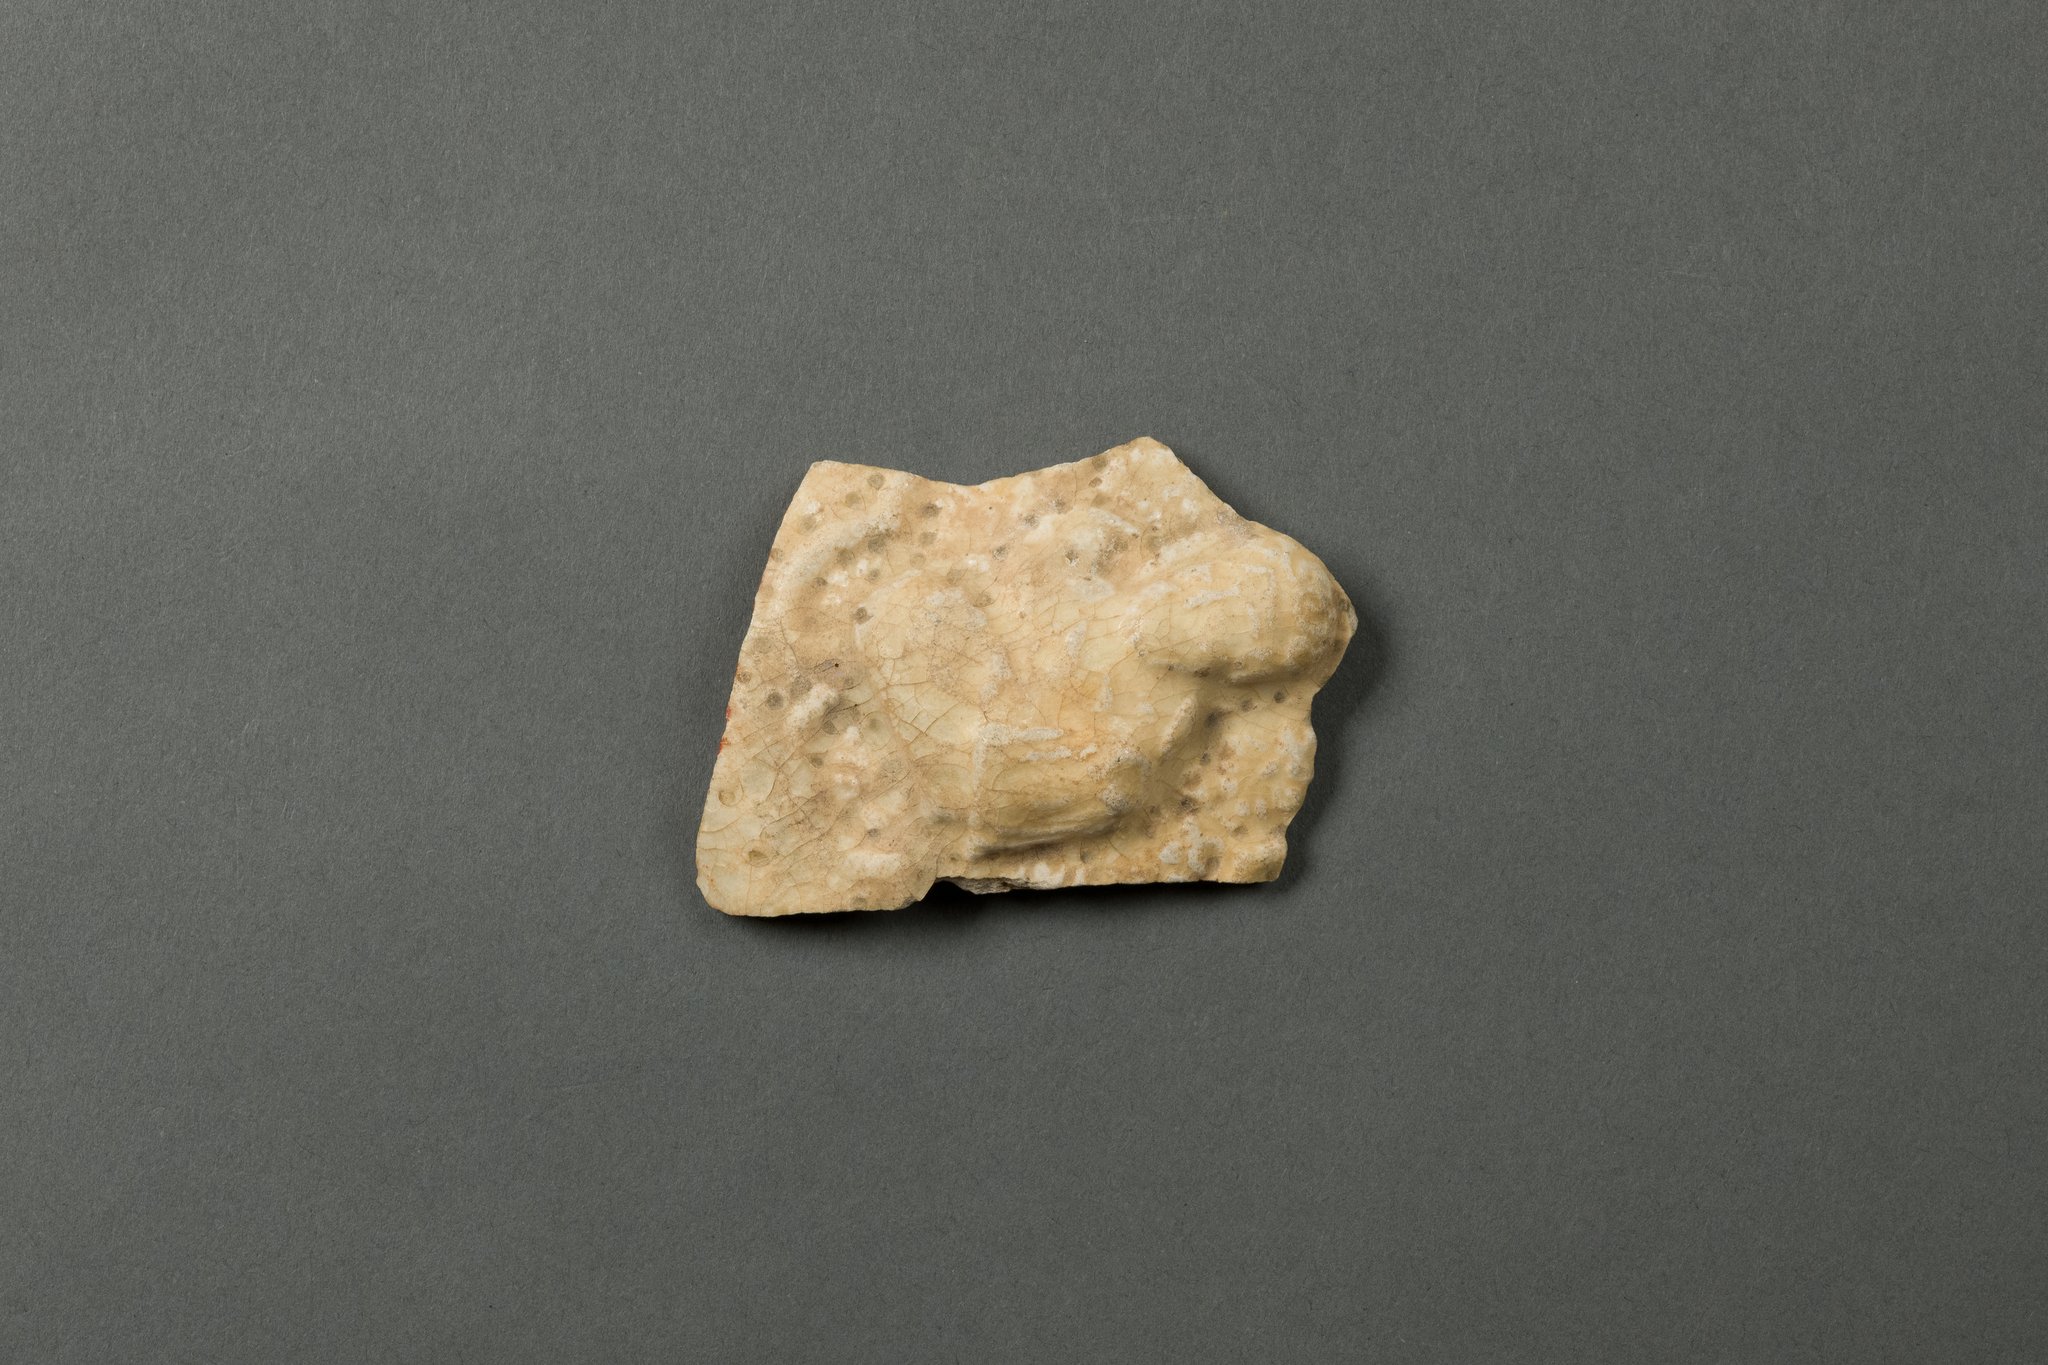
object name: fragment of an ewer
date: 1001-1200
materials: glaze, stonepaste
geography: iran